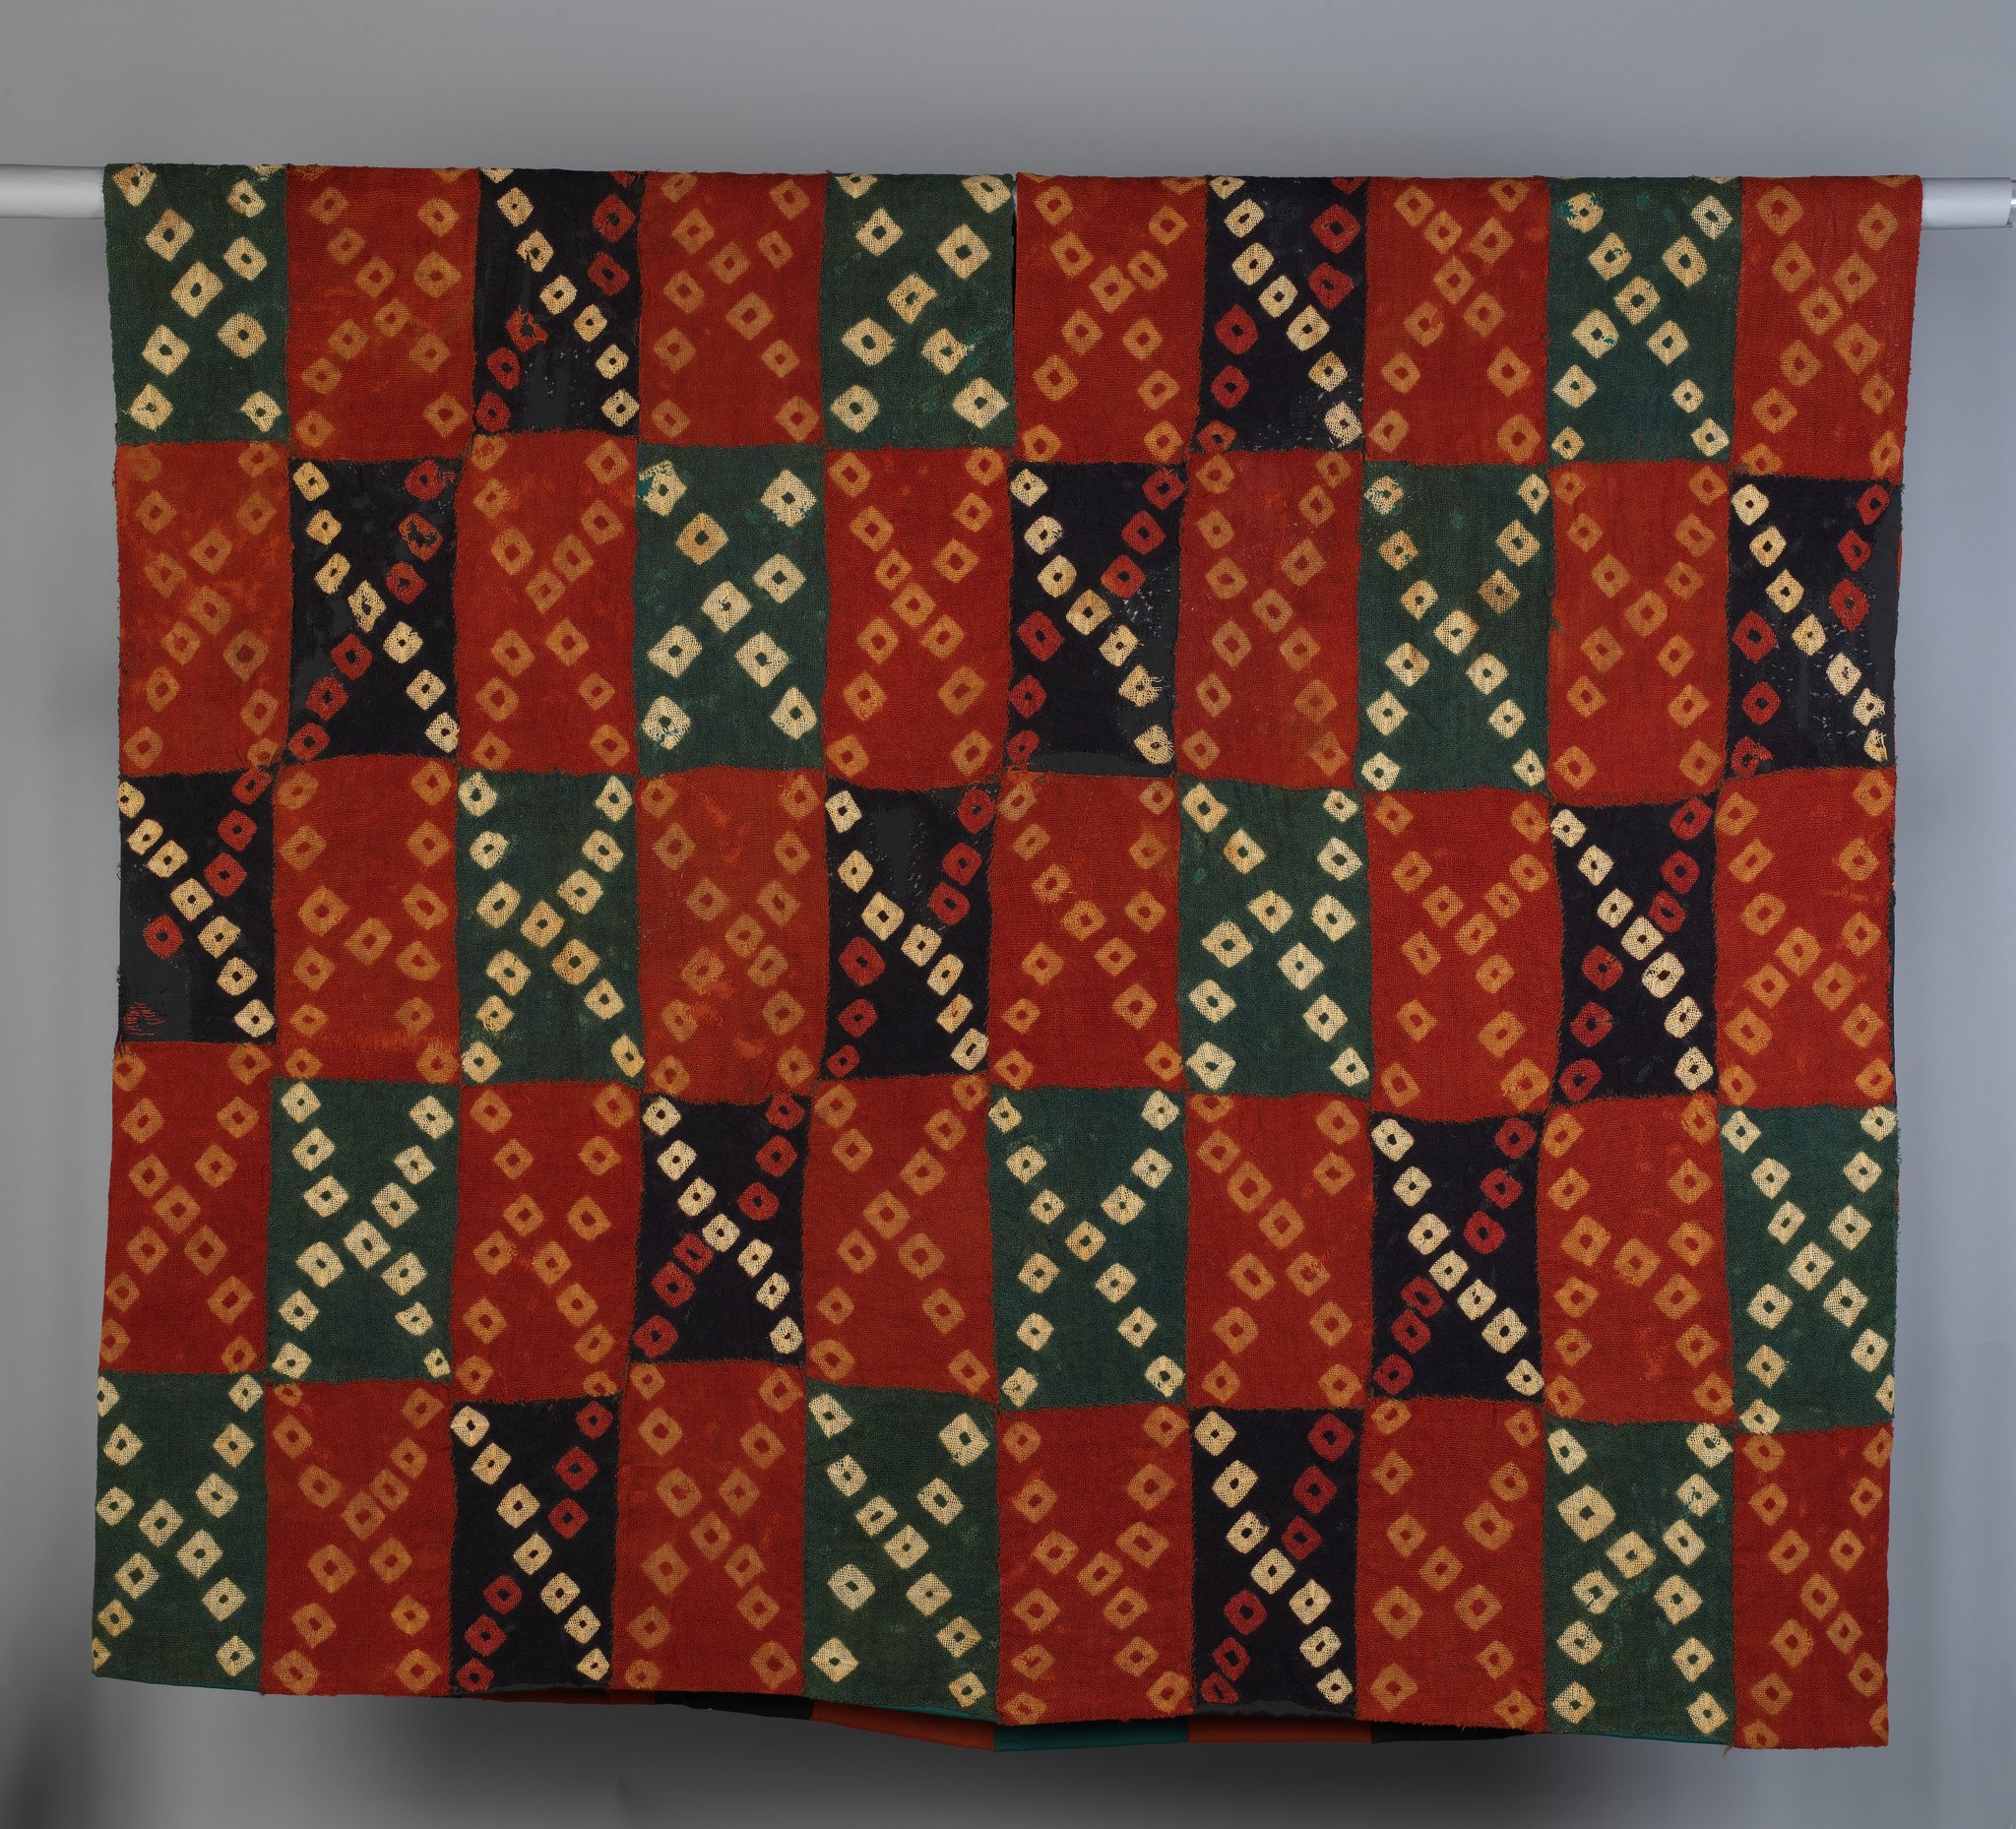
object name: tunic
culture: wari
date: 425-550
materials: animal fiber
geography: peru